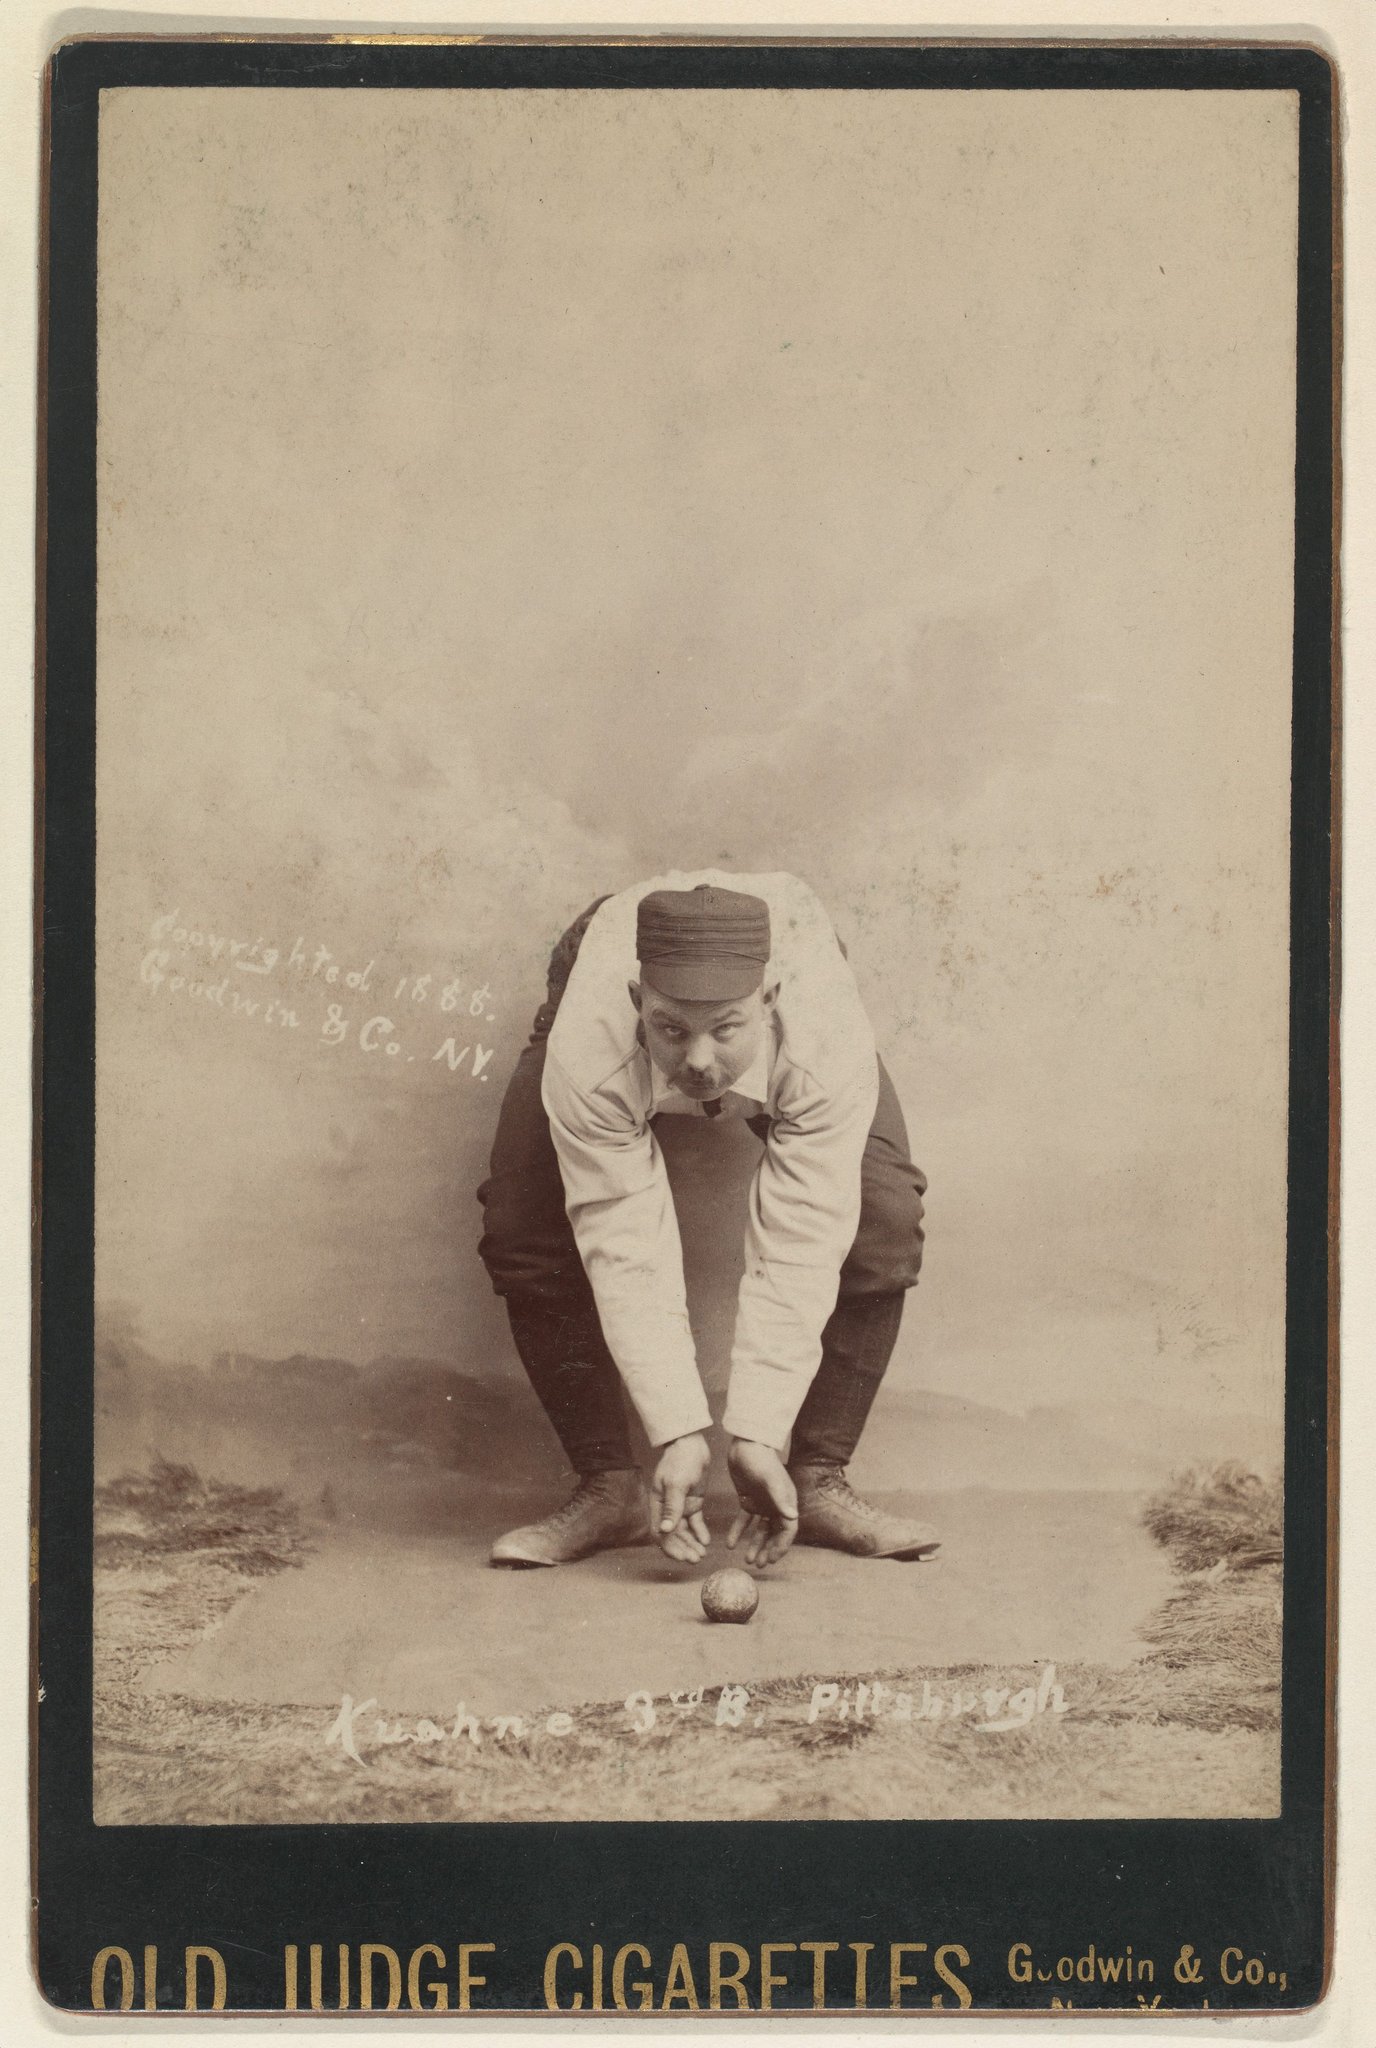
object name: baseball card, photograph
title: Kuehne, 3rd Base, Pittsburgh, from the series Old Judge Cigarettes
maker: goodwin & company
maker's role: publisher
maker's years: 1850-1950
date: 1888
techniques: albumen print, photography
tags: men,portraits,baseball,athletes